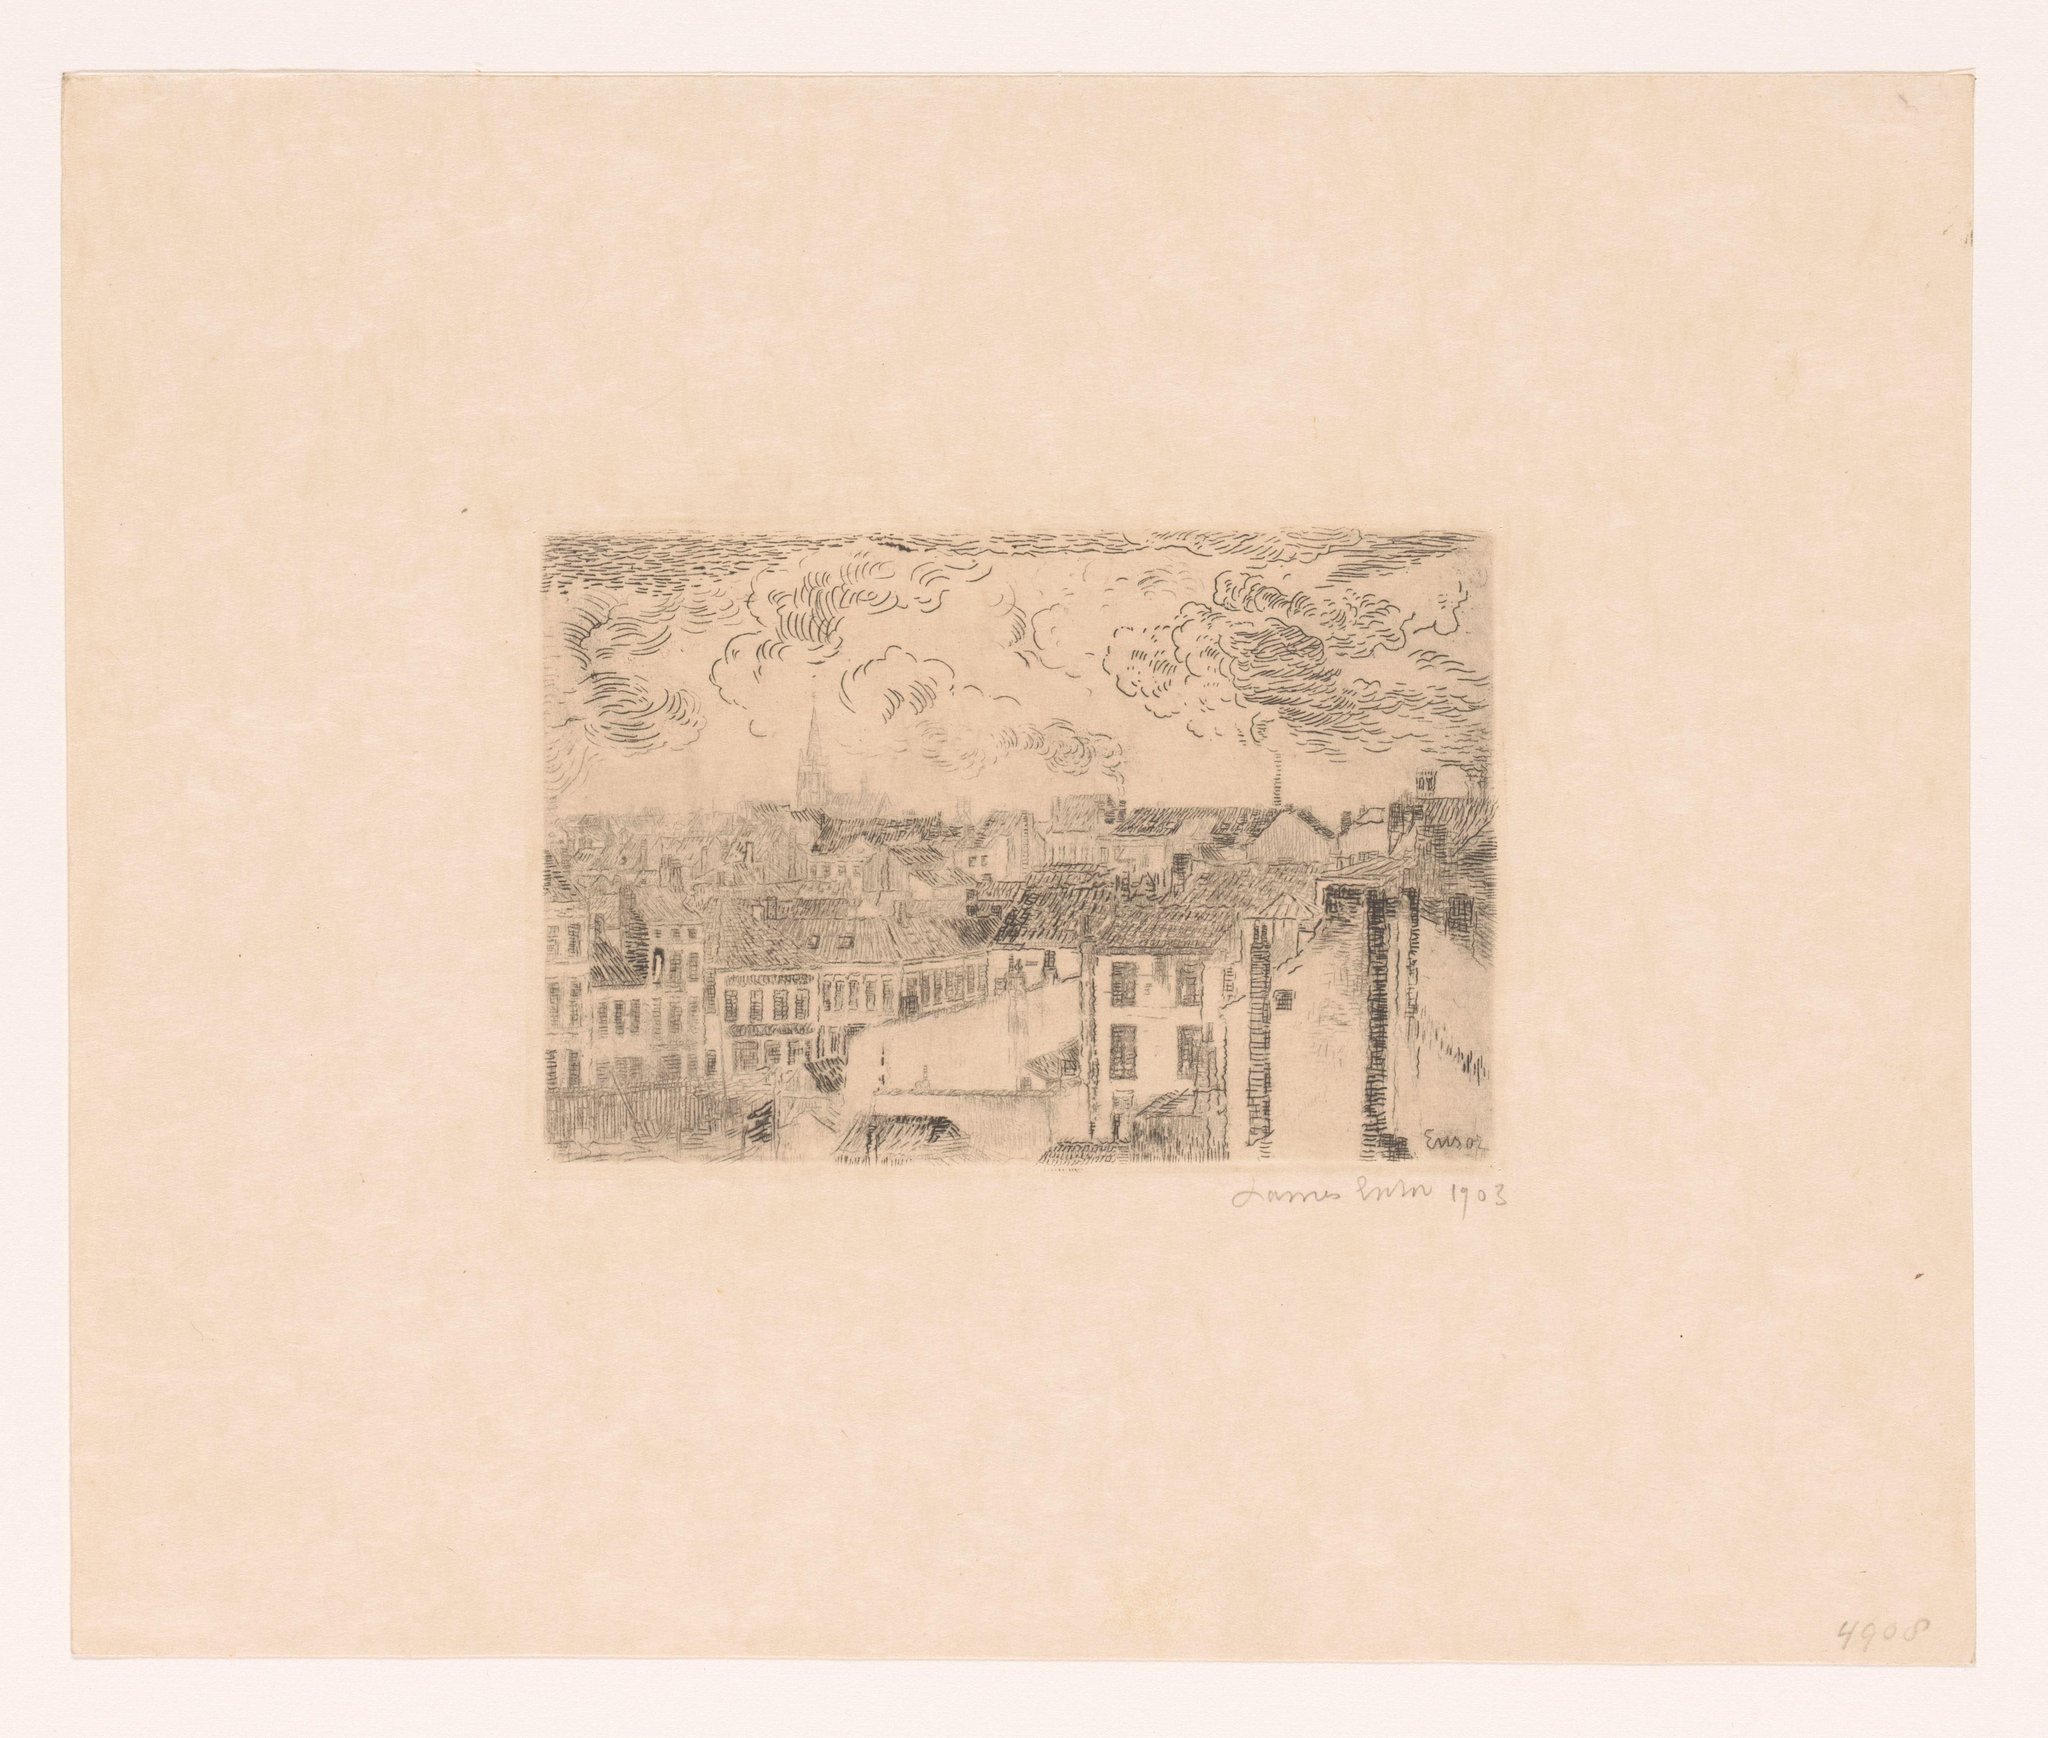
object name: print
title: Les toits d'Ostende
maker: james ensor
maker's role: print maker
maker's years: 1860-1949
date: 1903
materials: paper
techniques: etching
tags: city-view in general; 'veduta'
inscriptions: collector's mark: Lugt 2228